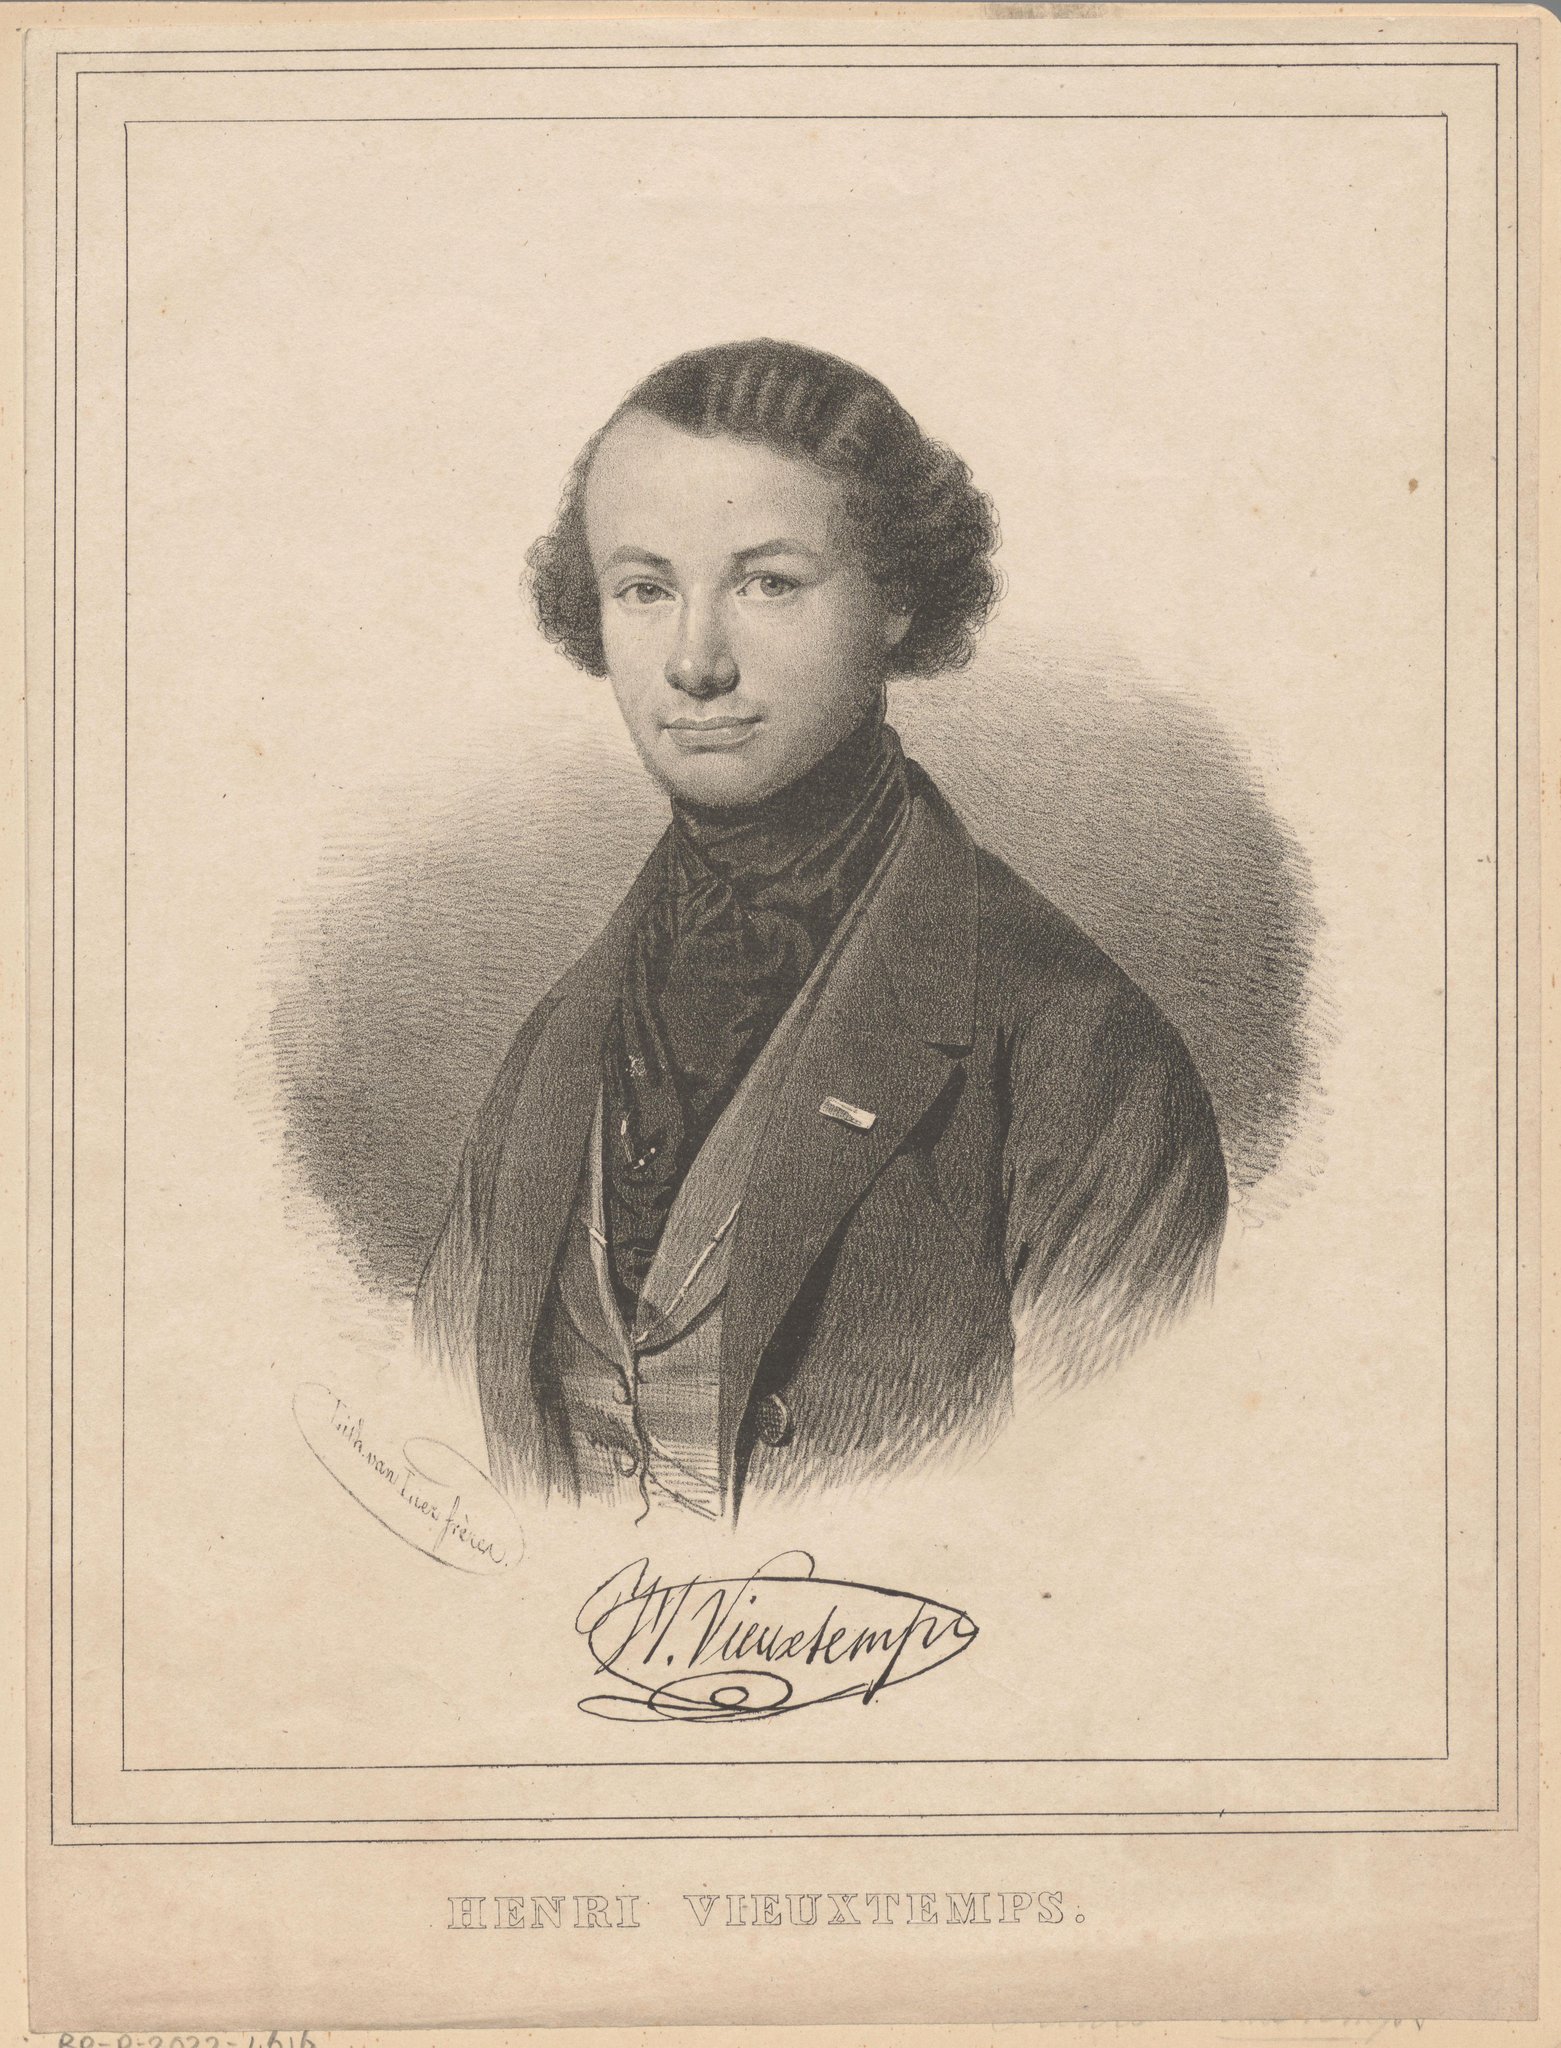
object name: print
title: Portret van Henri Vieuxtemps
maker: Anonymous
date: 1840-1846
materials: paper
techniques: lithograph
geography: the hague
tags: historical persons, portrait of composer